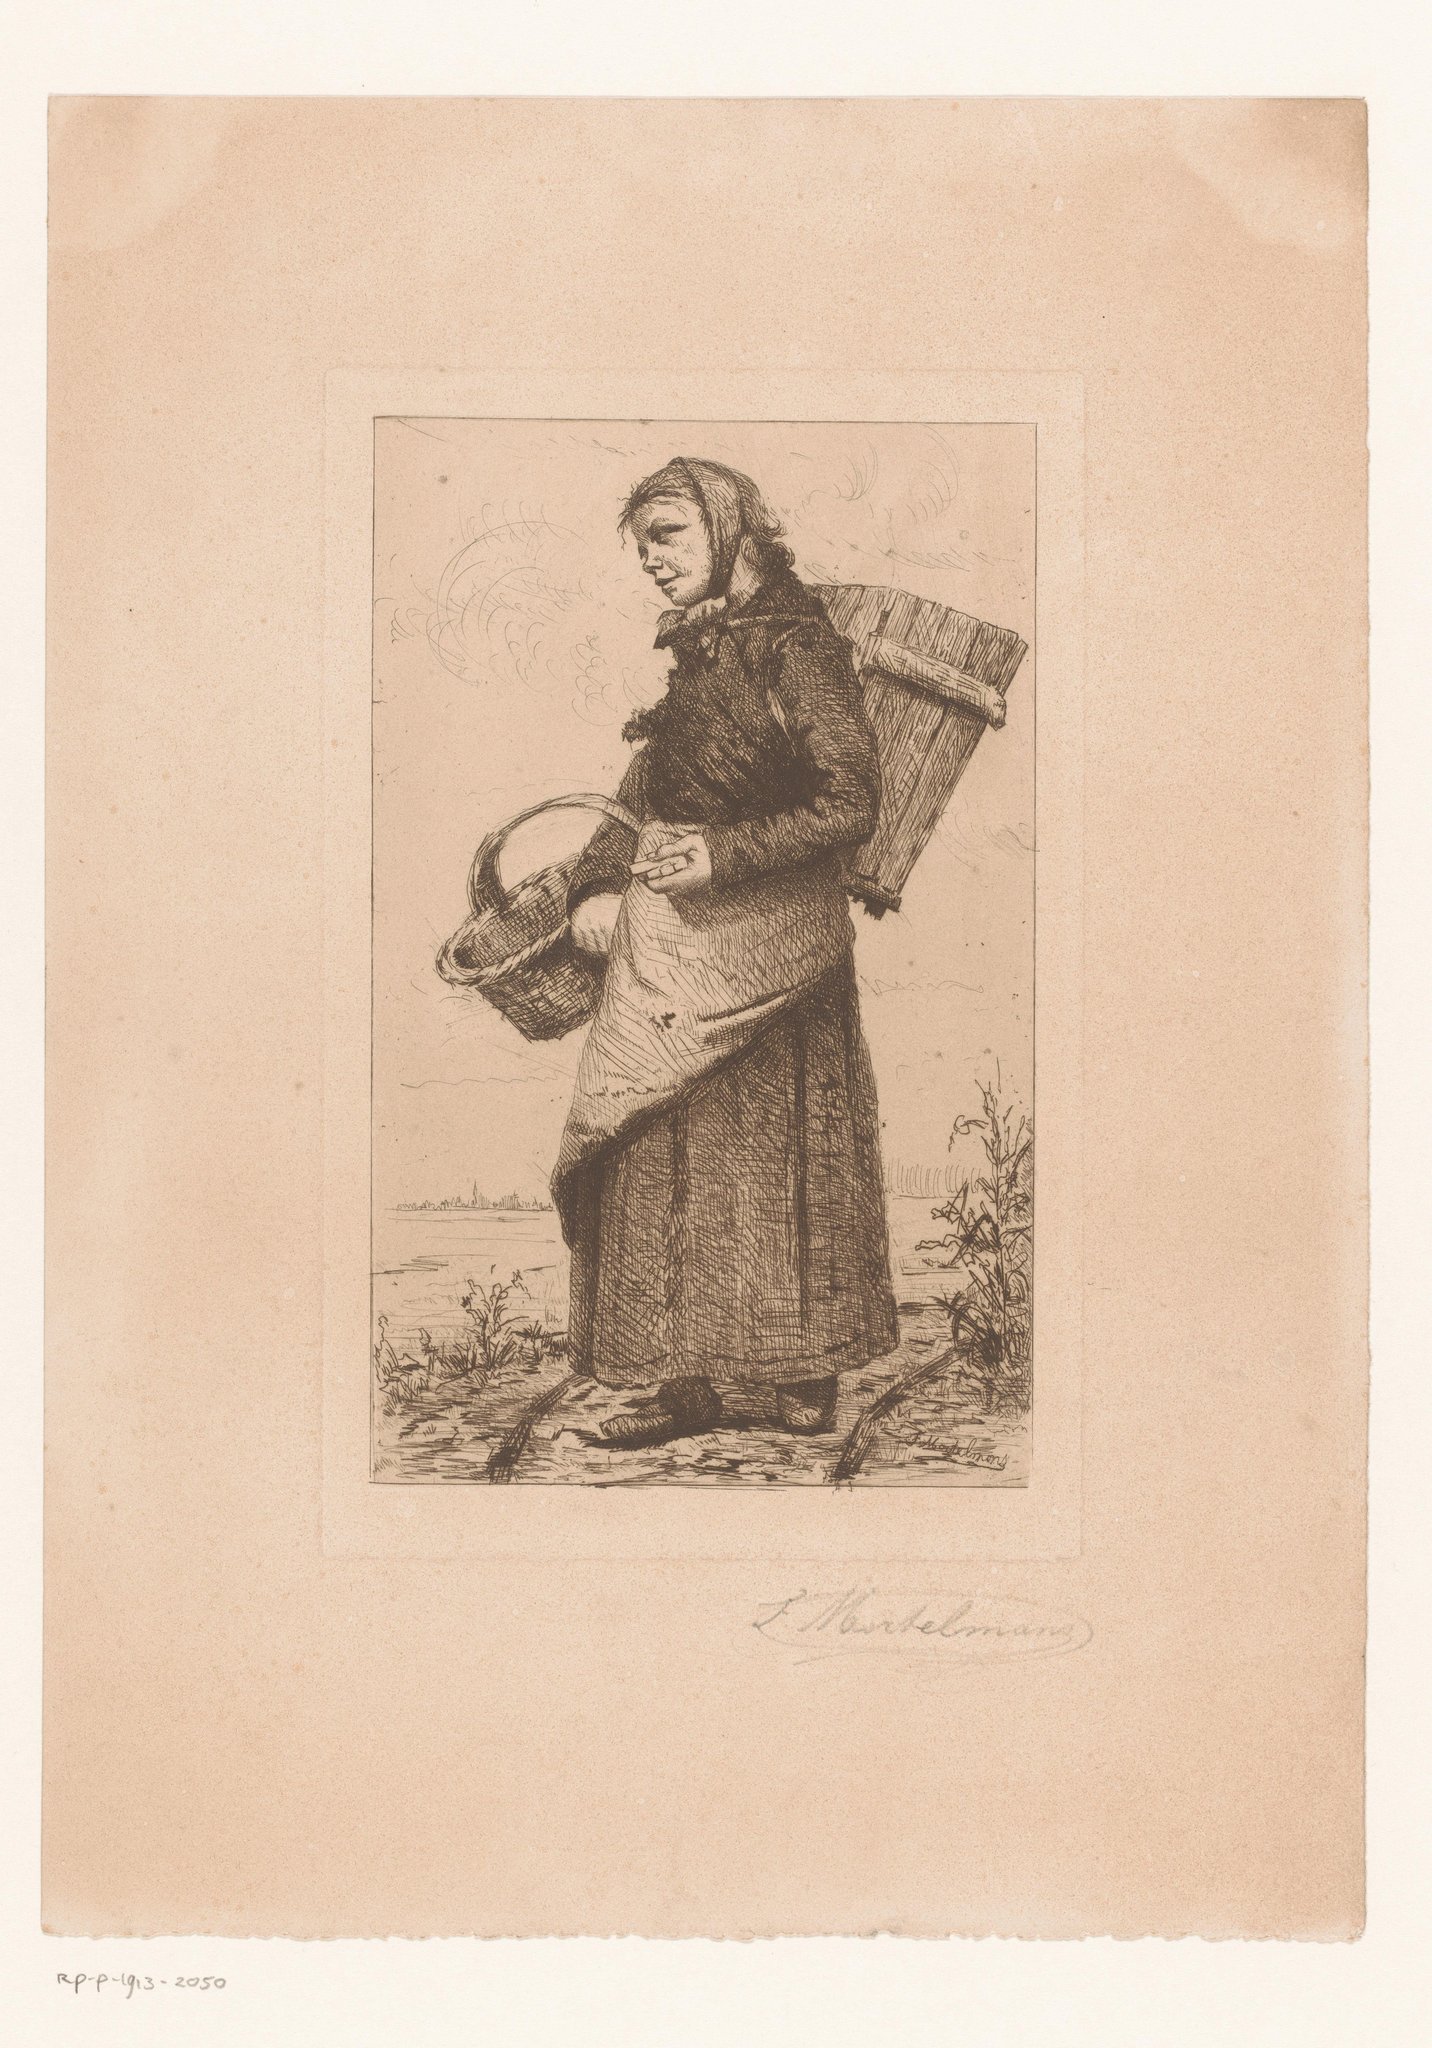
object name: print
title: Krijtverkoopster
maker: frans mortelmans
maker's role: print maker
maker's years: 1865-1936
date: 1875-1913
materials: paper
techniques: etching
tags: adult woman, carrying something in basket, bag, rucksack, etc., selling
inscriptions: collector's mark: Lugt 2228